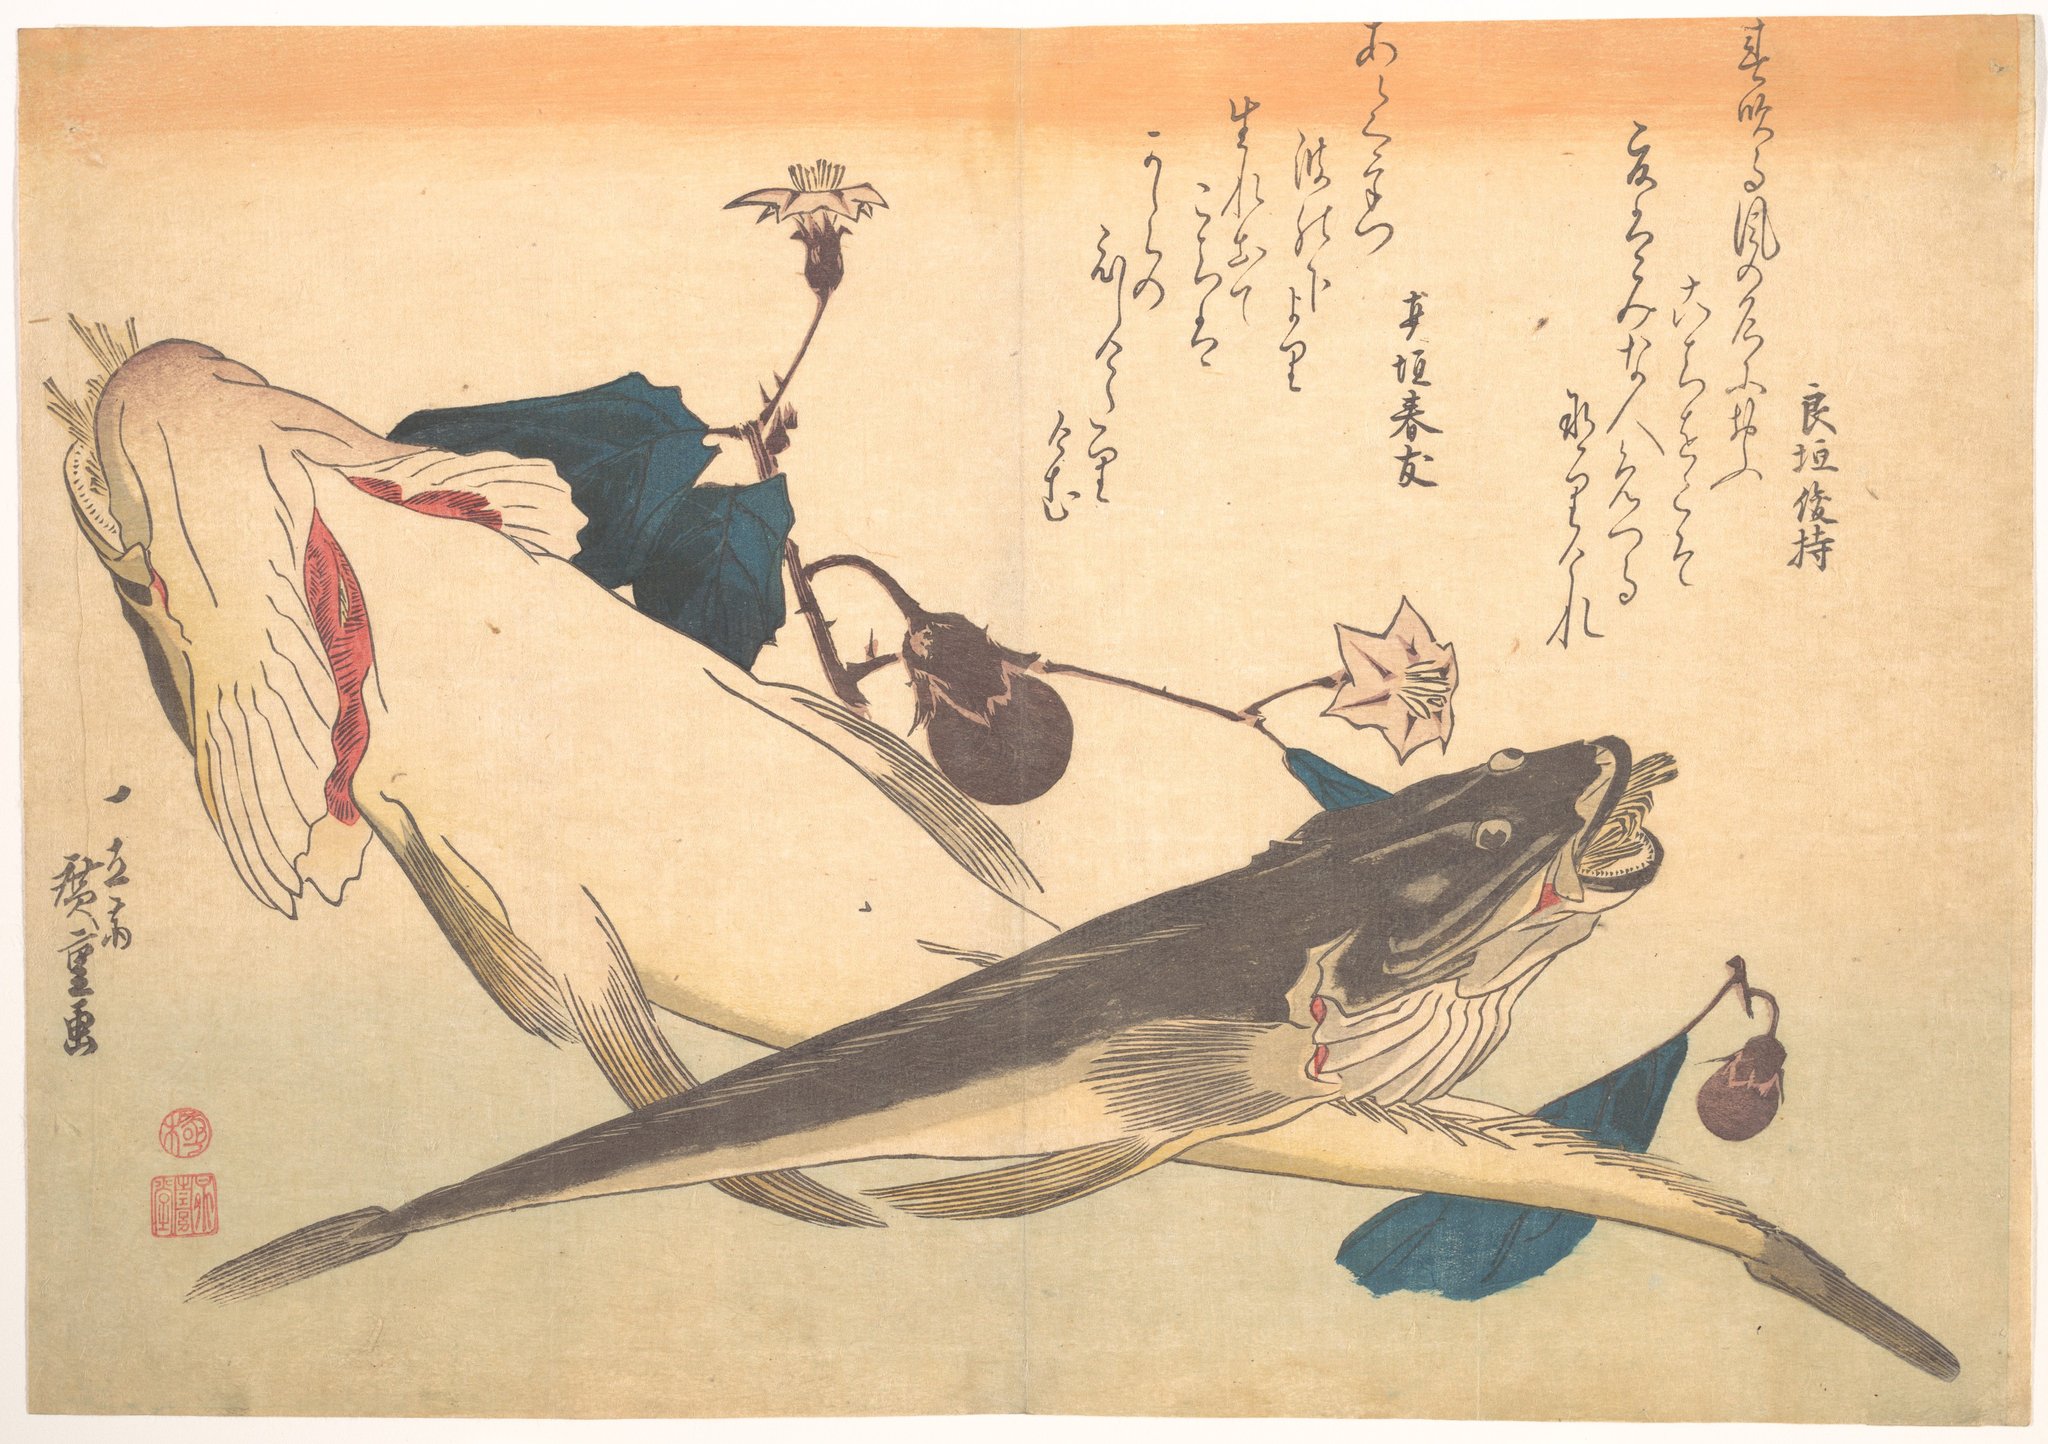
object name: woodblock print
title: Kochi Fish with Eggplant, from the series Uozukushi (Every Variety of Fish)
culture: japanese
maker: utagawa hiroshige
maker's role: artist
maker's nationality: japanese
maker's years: 1797-1858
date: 1830-1839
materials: ink, paper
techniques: woodblock print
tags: eggplants,fish